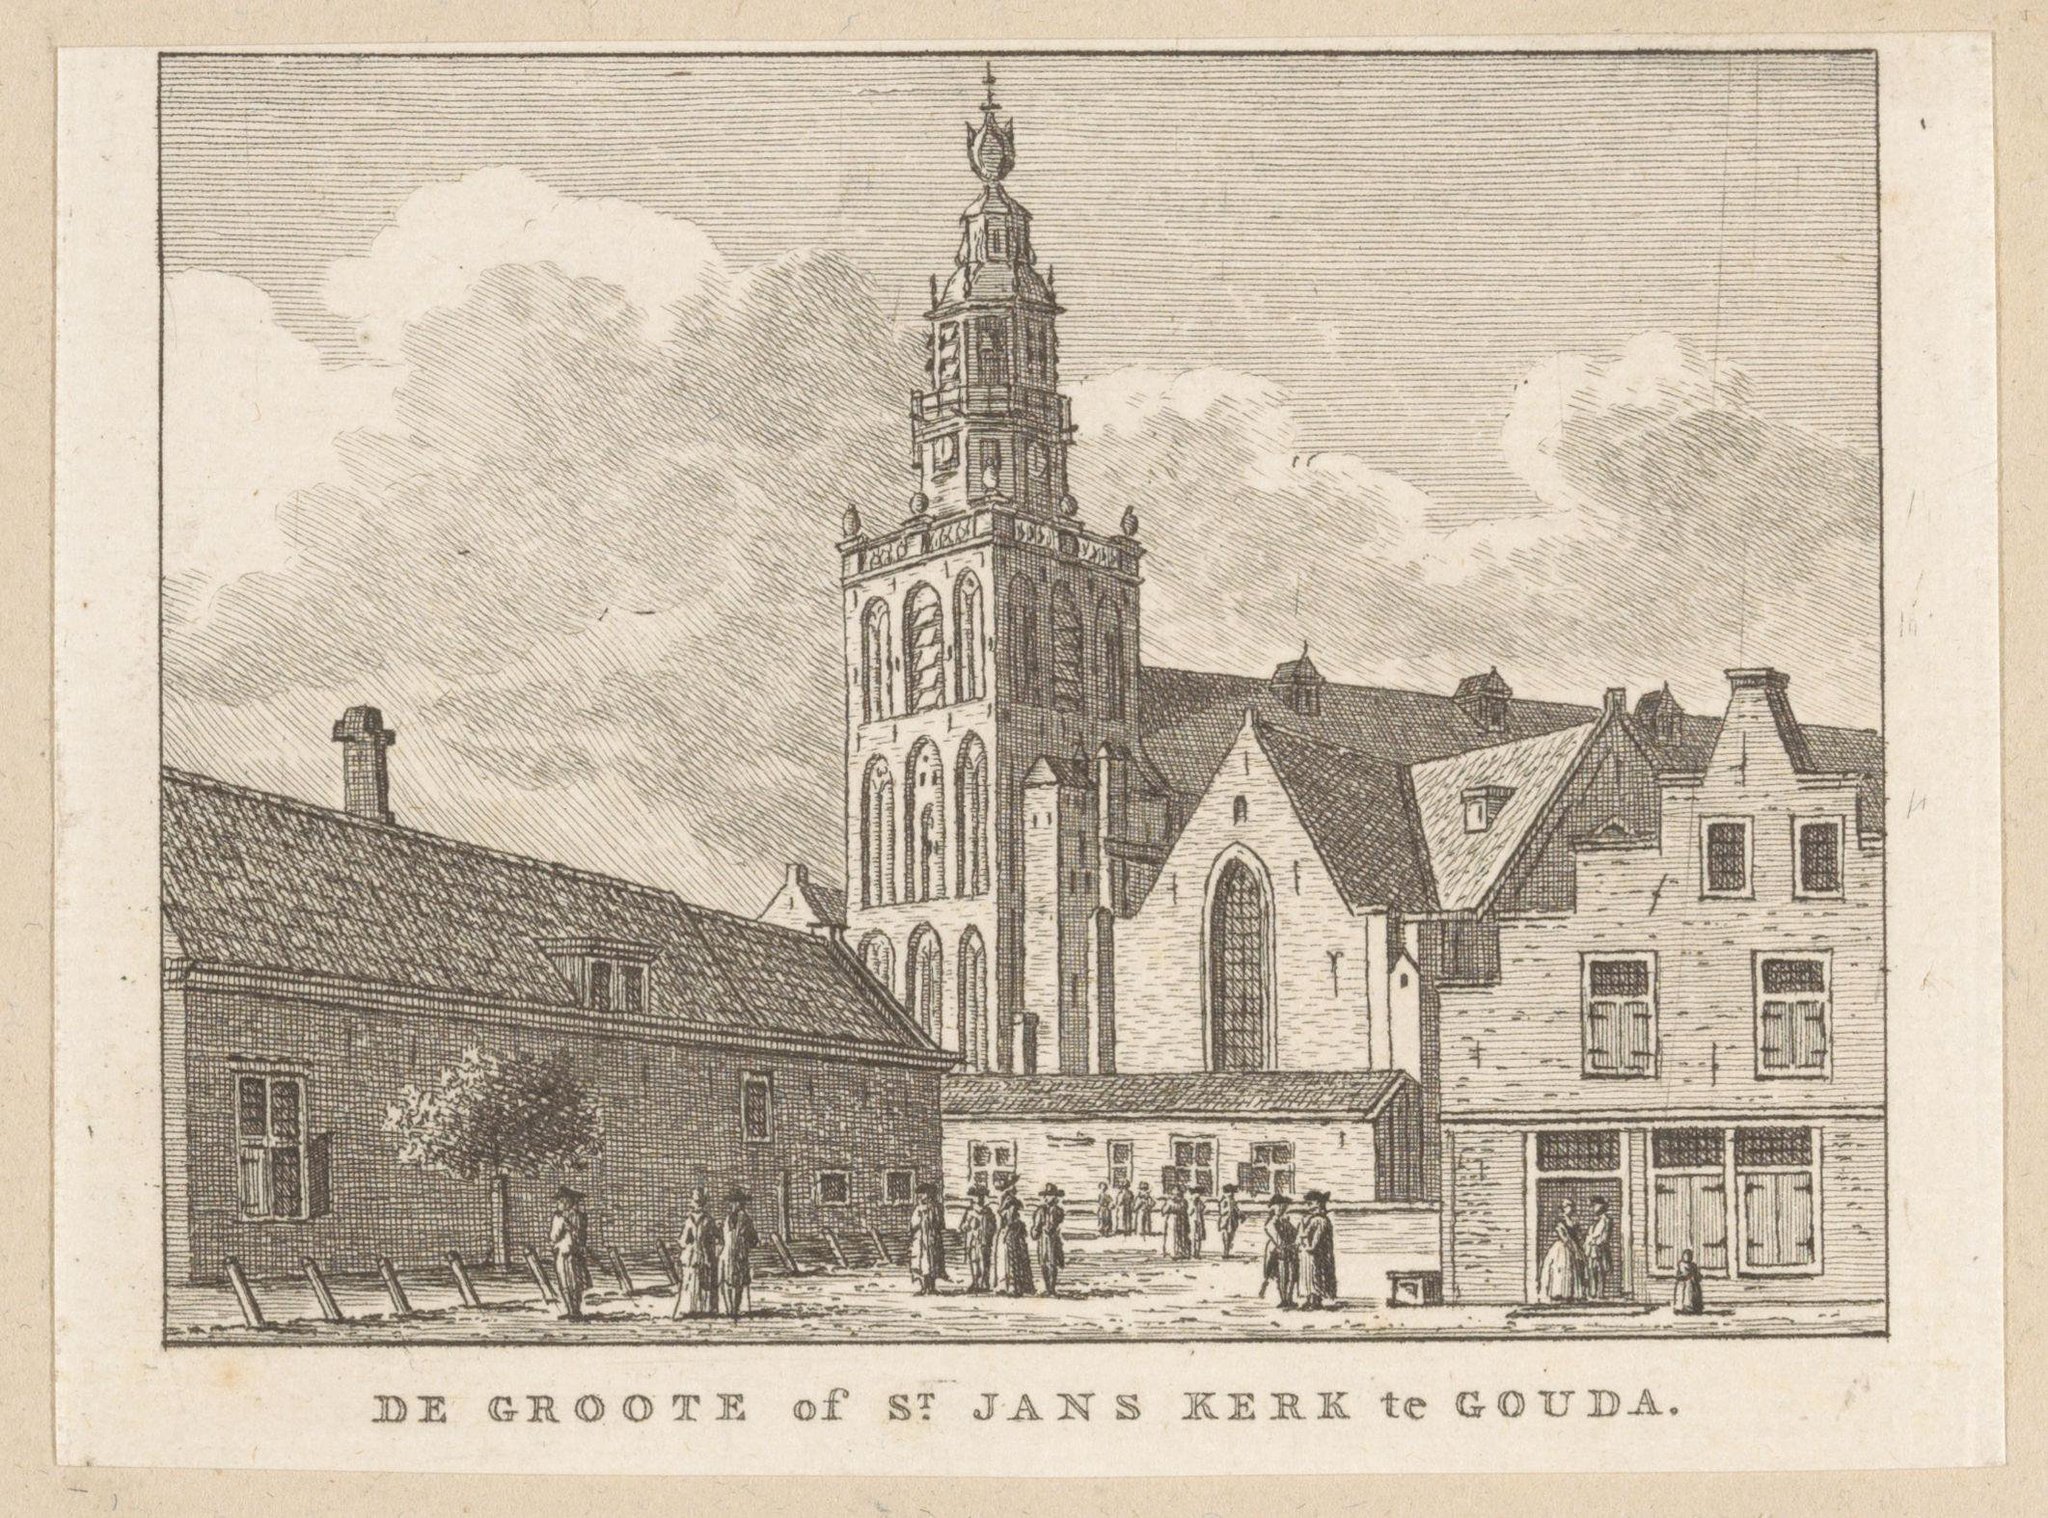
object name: print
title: De Groote of St. Jans Kerk te Gouda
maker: carel frederik bendorp (i)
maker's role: print maker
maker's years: 1736-1814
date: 1786-1792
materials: paper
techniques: engraving, etching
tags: church (exterior)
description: Prent uit: Vaderlandsche gezichten, of afbeeldingen van den tegenwoordigen staat der Vereenigde Nederlanden (…). Amsterdam: Hendrik Gartman, Willem Vermandel en Jan Willem Smit, 1786-1792. Uitgegeven in afleveringen met ieder een eigen bifolium en inhoudsopgave. Alle prenten in deze publicatie zijn gegraveerd door Carel Frederik Bendorp (I) en, in de meeste gevallen, gebaseerd op tekeningen van Jan Bulthuis.